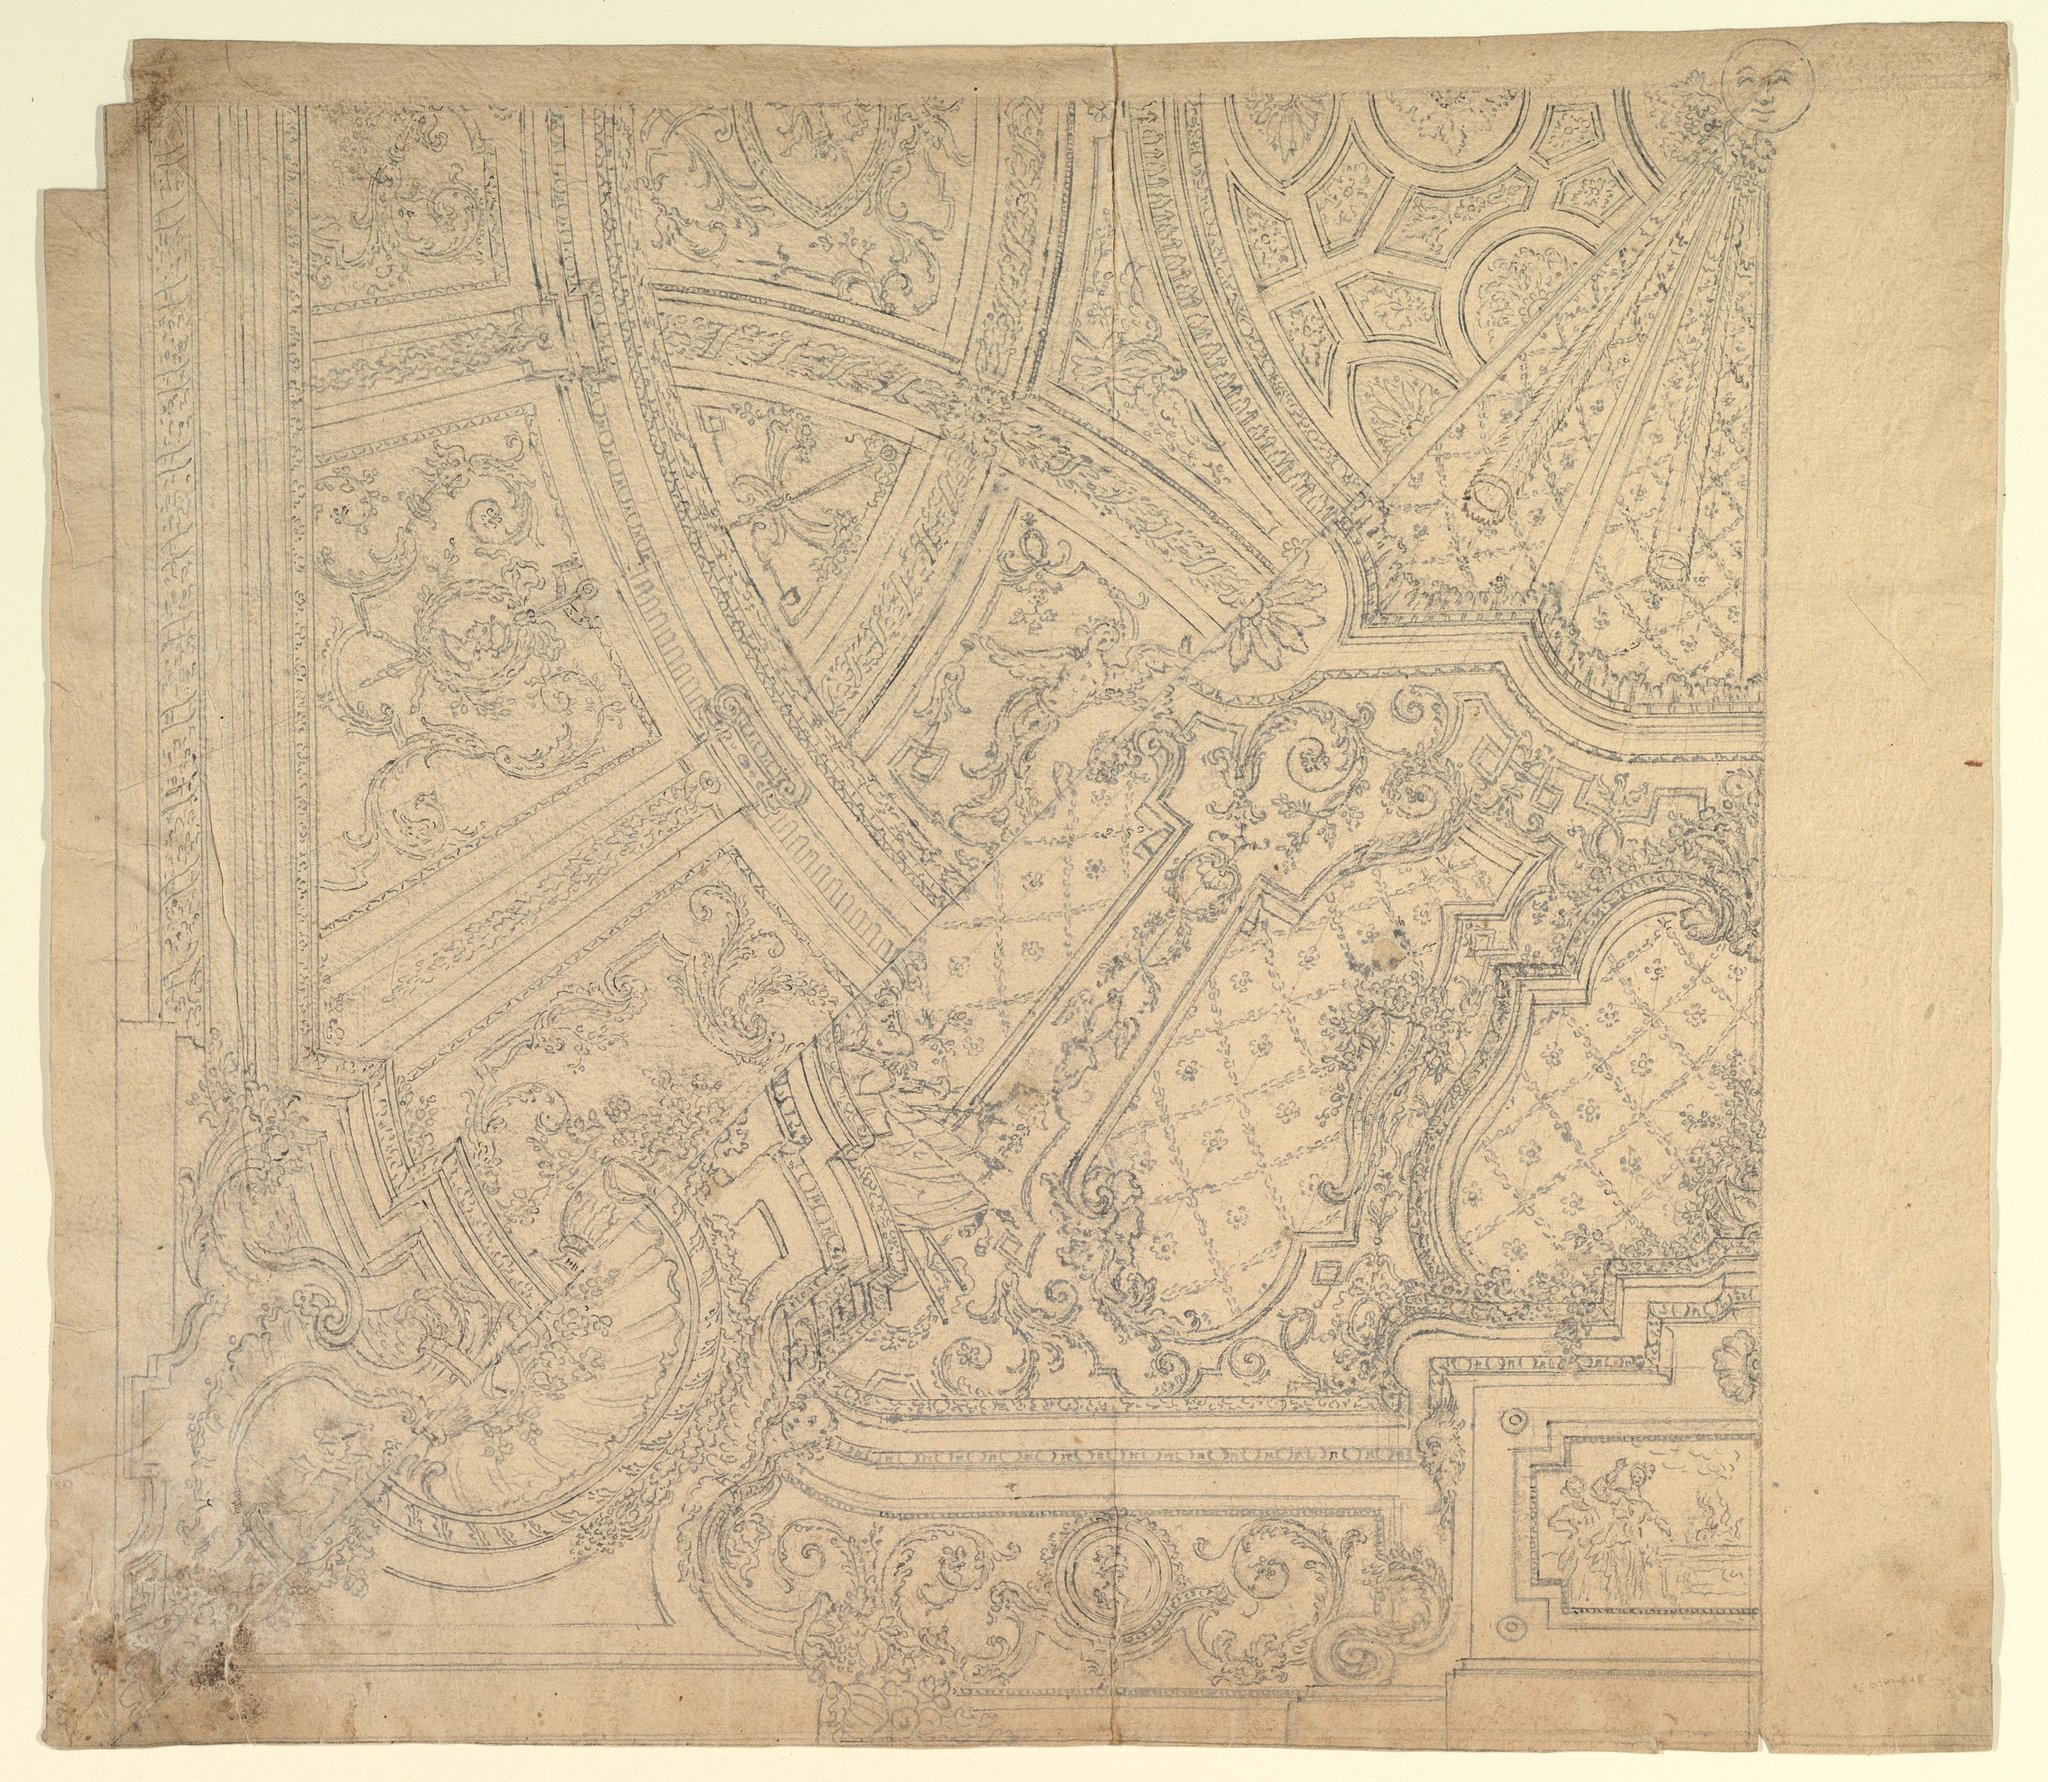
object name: drawing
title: Halved Alternate Designs for a Ceiling Painting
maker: leonardo marini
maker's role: artist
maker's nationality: italian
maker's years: 1730-1797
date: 1700-1780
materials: chalk, ink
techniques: pen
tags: ceilings